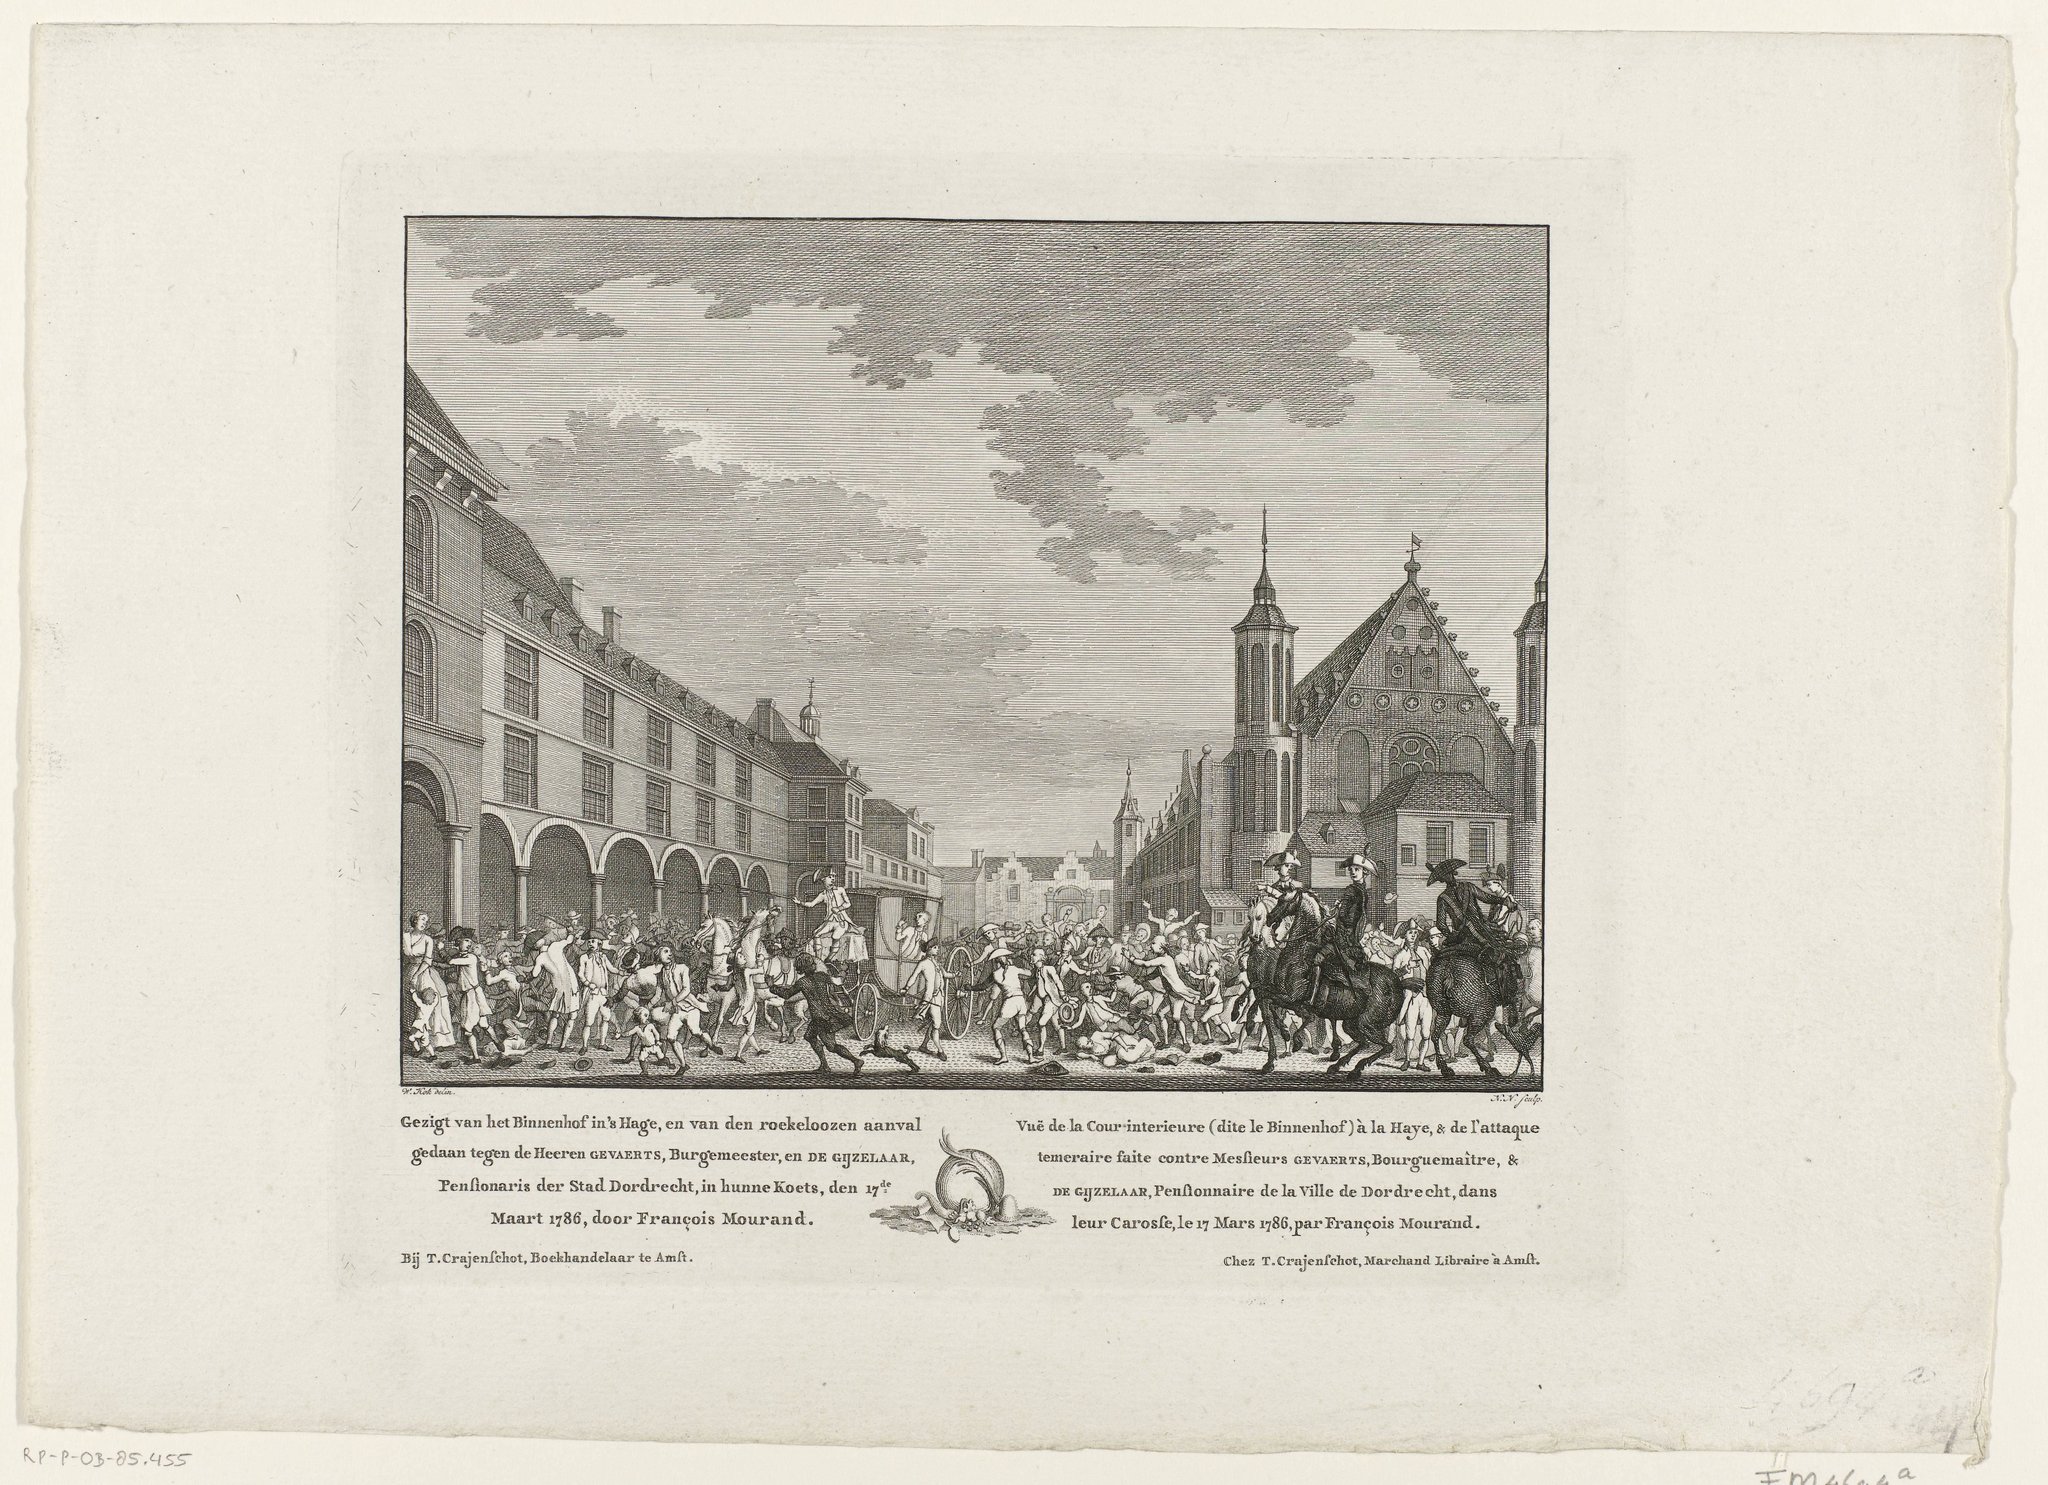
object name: print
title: Gezigt van het Binnenhof in 's Hage, en van de roekeloozen aanval gedaan (...) / Vuë de la Cour interieure (dite le Binnenhof) à la Haye, & de l'attaque temaire faite (...)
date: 1786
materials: paper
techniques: etching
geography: northern netherlands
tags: revolutionary action (violent)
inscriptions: collector's mark: Lugt 2228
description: Ongeregeldheden als de gedeputeerden van Dordrecht, de heren Gevaerts en De Gijzelaar, met hun rijtuig door de Stadhouderspoort het Binnenhof op rijden en hun paarden bij de toom worden gegrepen door de Haagse pruikenmaker F. Mourand, 17 maart 1786. In het onderschrift een vignetje en de titels in het Nederlands en Frans.